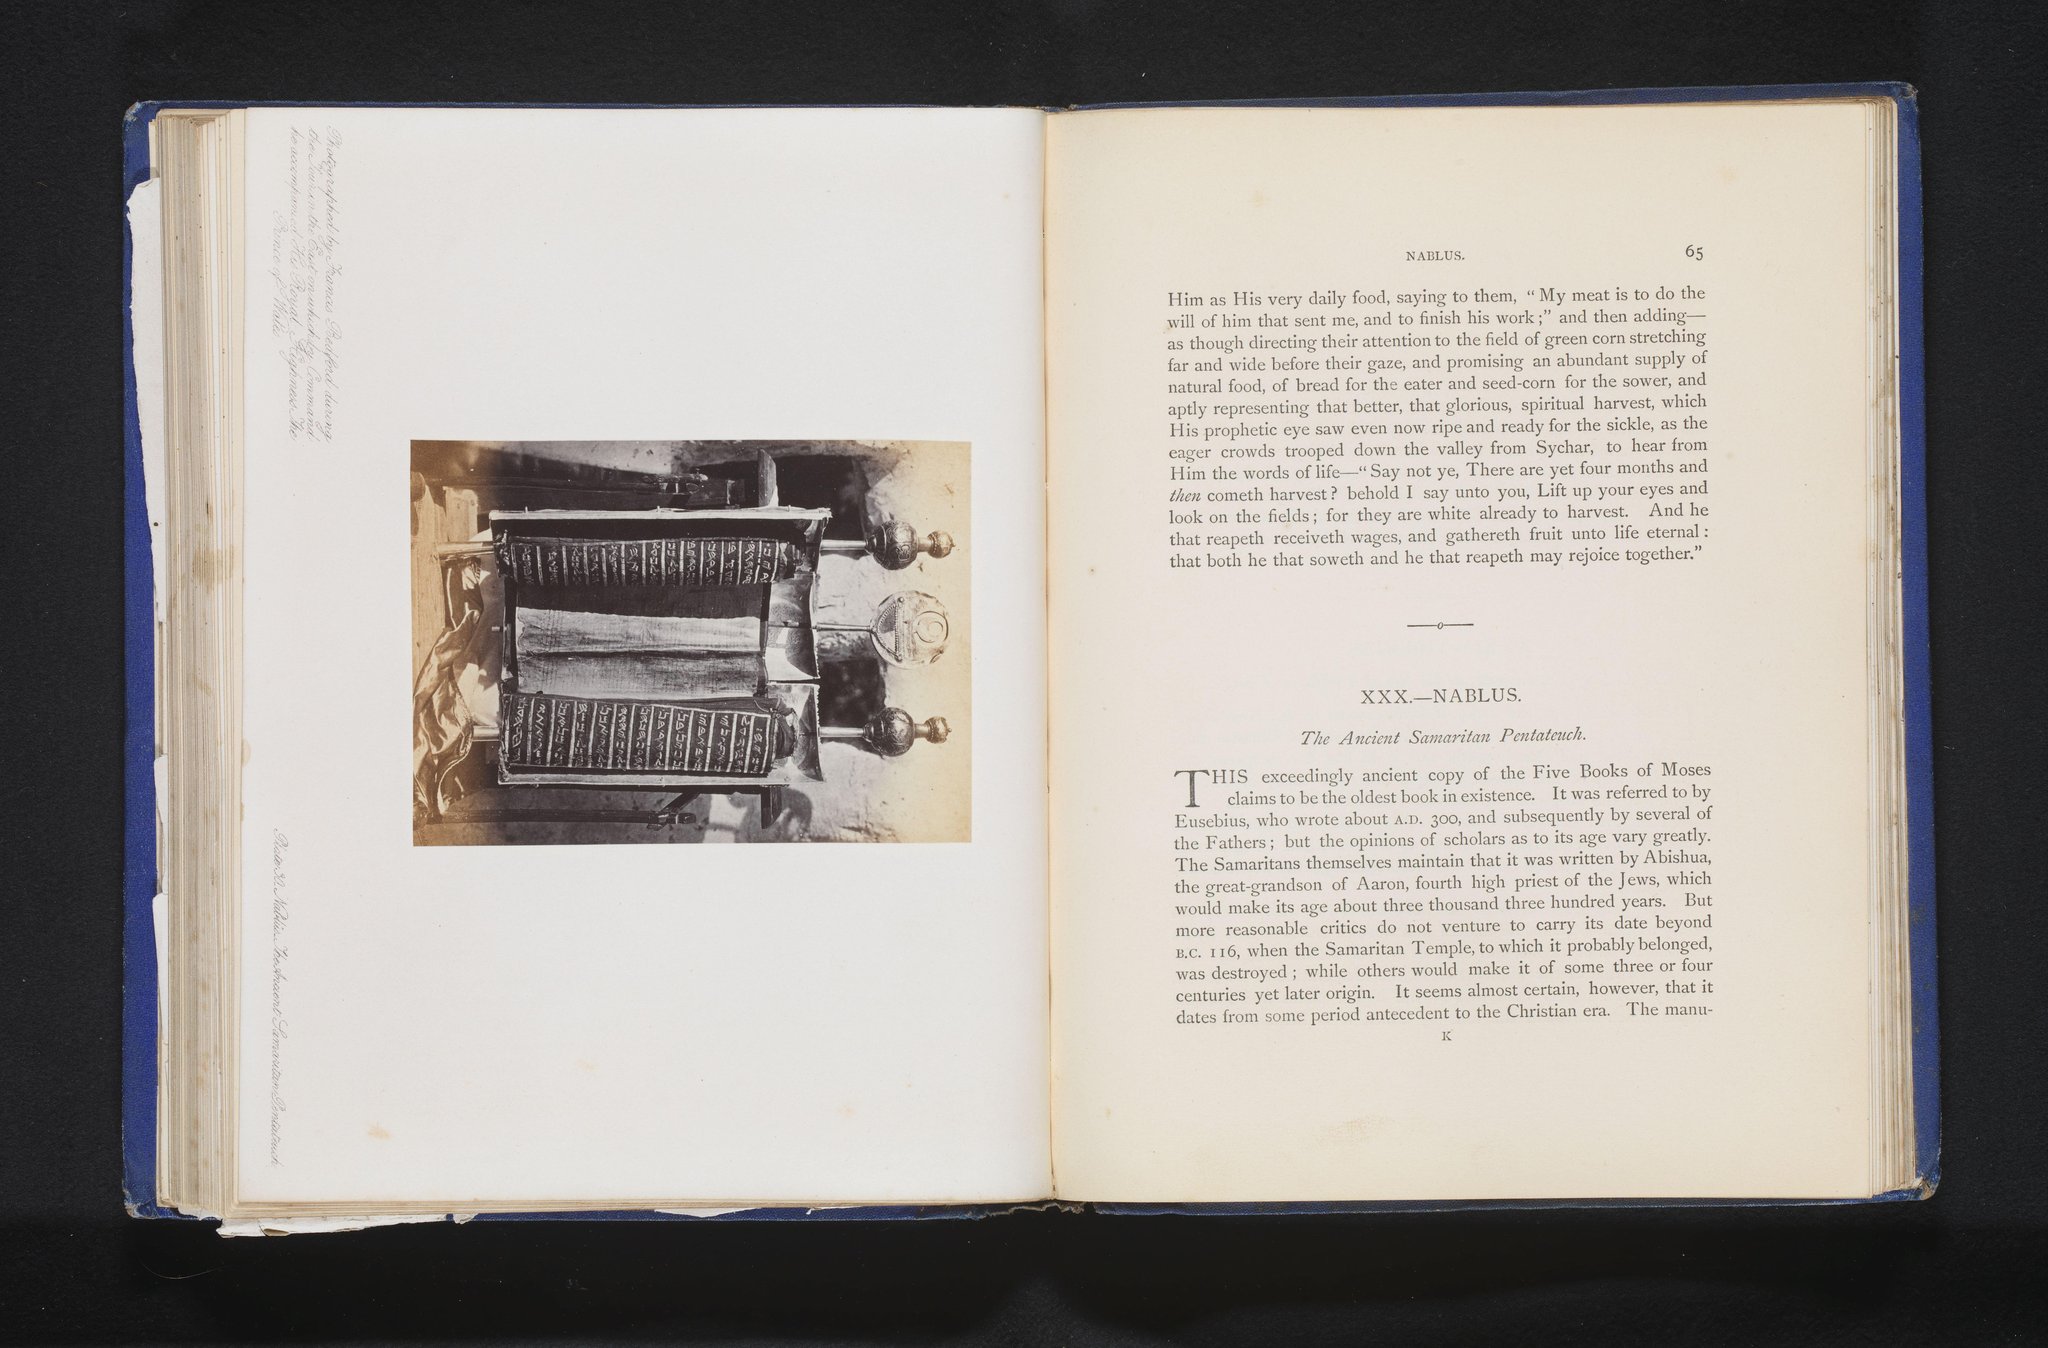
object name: photograph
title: Nablûs-The ancient Samaritan Pentateuch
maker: francis bedford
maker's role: print maker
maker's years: 1815-1894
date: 1861-1866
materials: photographic support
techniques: albumen print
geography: nabloes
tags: scroll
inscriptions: number: ‘Plate 30.’, inscription: ‘Photographed by Francis Bedford during the Tour in the East on which by Command he accompanied His Royal Highness The Prince of Wales’